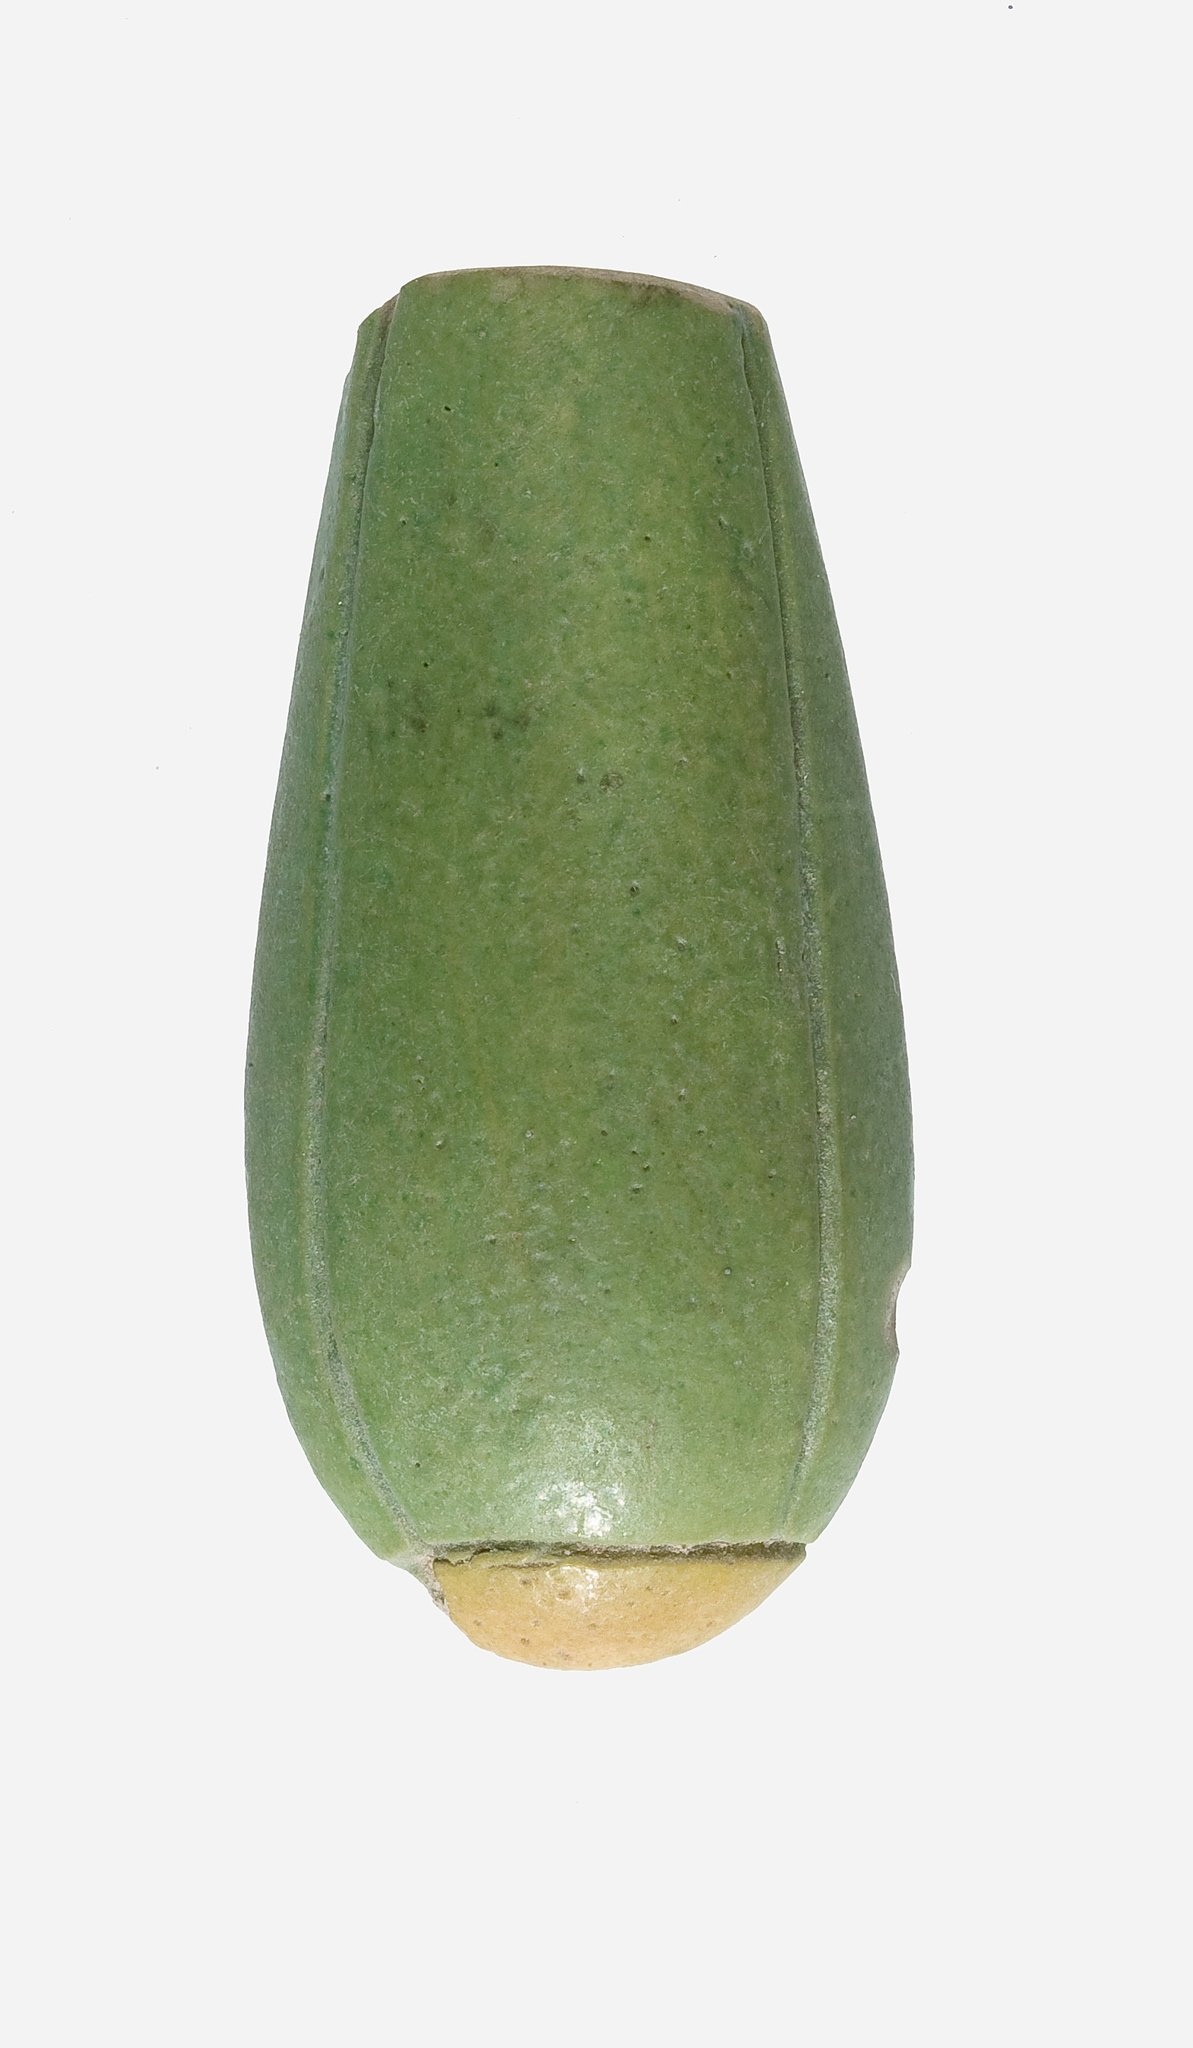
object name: ornament, lotus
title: Architectural Ornament: Lotus Bud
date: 1390-1352 BCE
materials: faience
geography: egypt